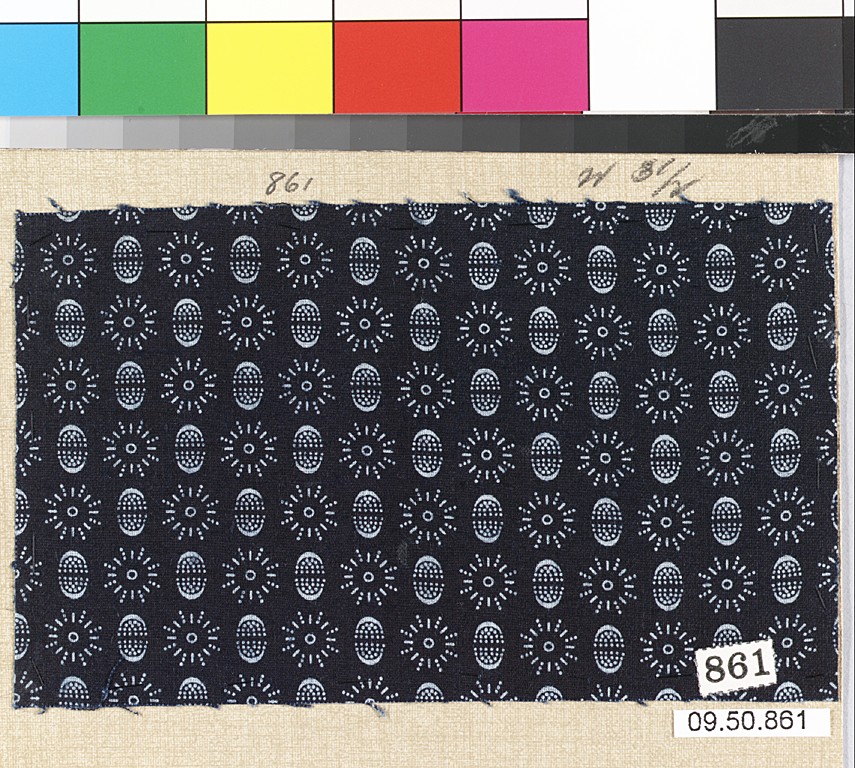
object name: piece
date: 1801-1900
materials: cotton